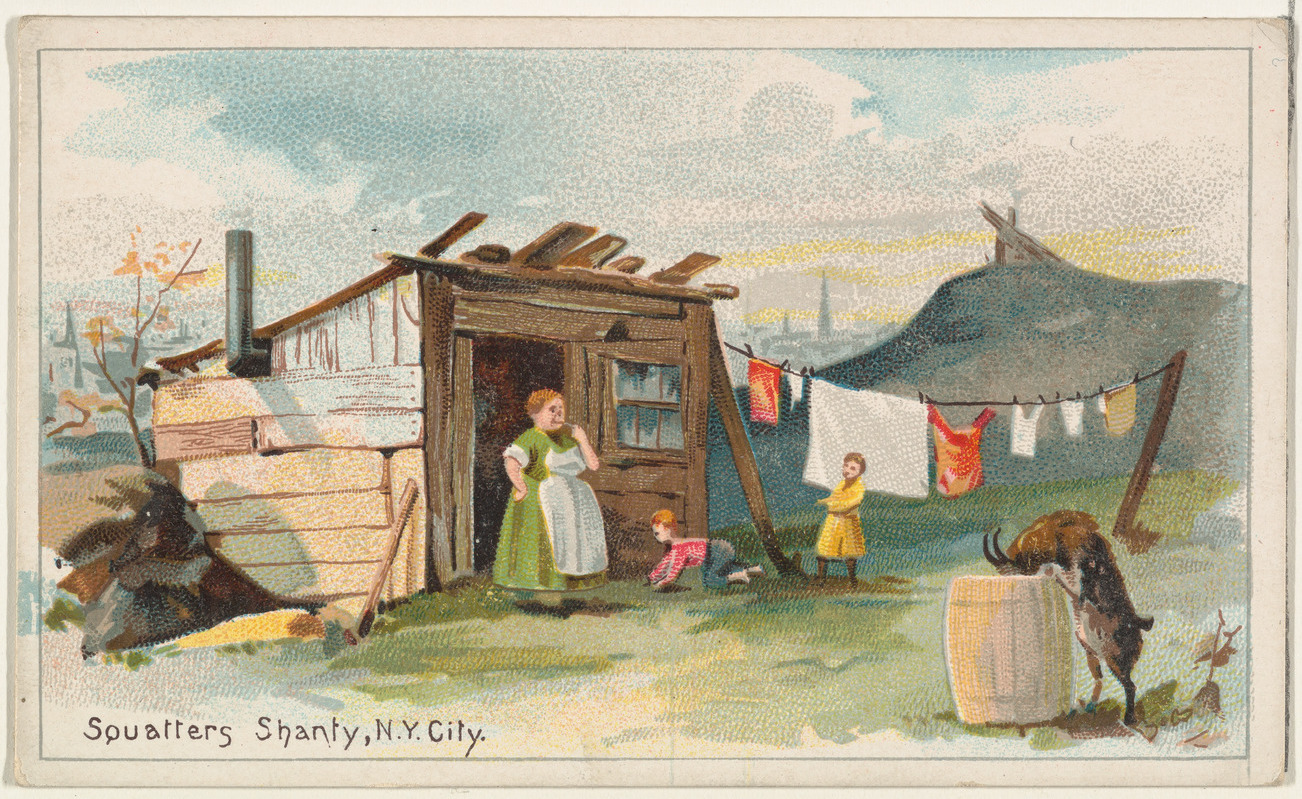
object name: print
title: Squatter's Shanty, New York City, from the Habitations of Man series (N113) issued by W. Duke, Sons & Co. to promote Honest Long Cut Smoking and Chewing Tobacco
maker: the giles company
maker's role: artist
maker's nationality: american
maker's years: 1800-1900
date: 1890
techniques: color lithograph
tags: children,women,goats